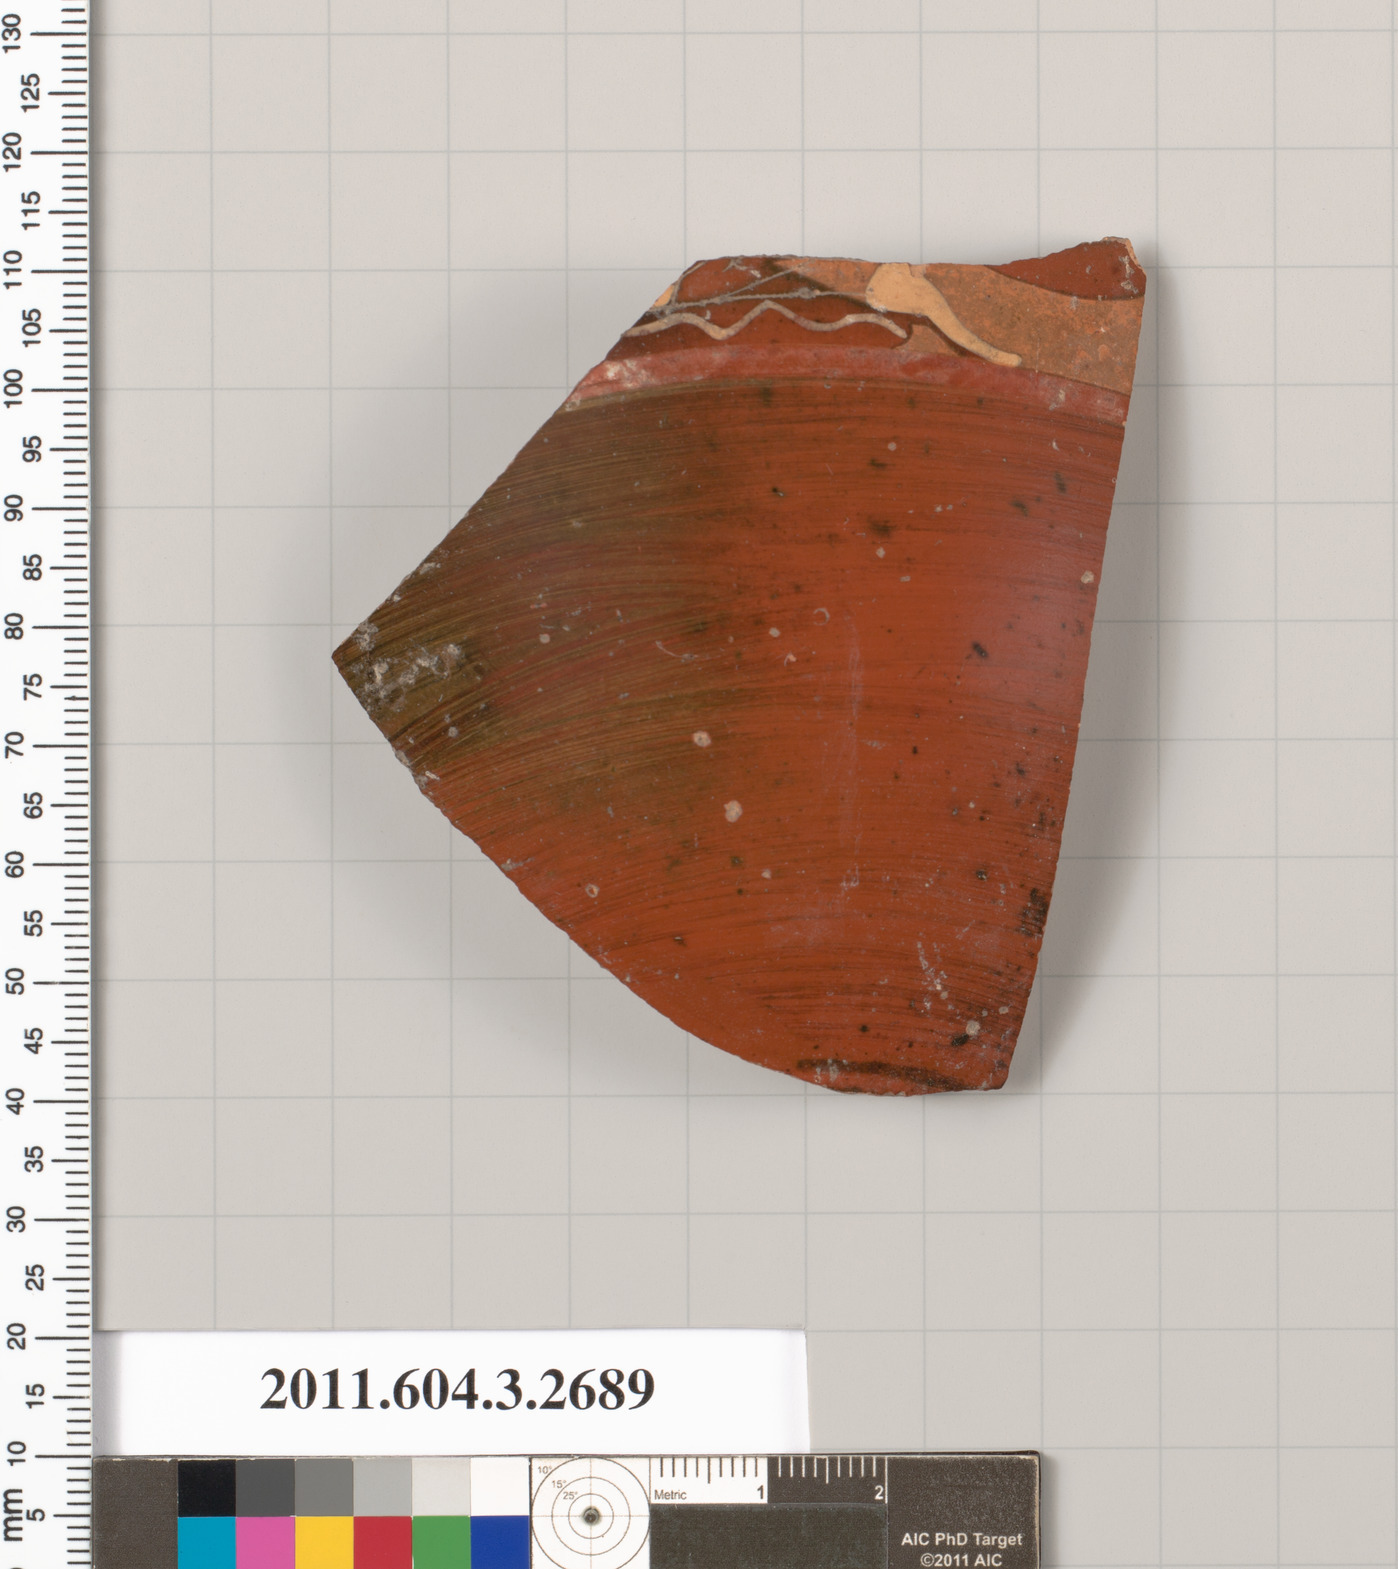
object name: oinochoe fragment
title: Terracotta fragment of an oinochoe (jug)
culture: greek, attic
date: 510-500 BCE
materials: terracotta